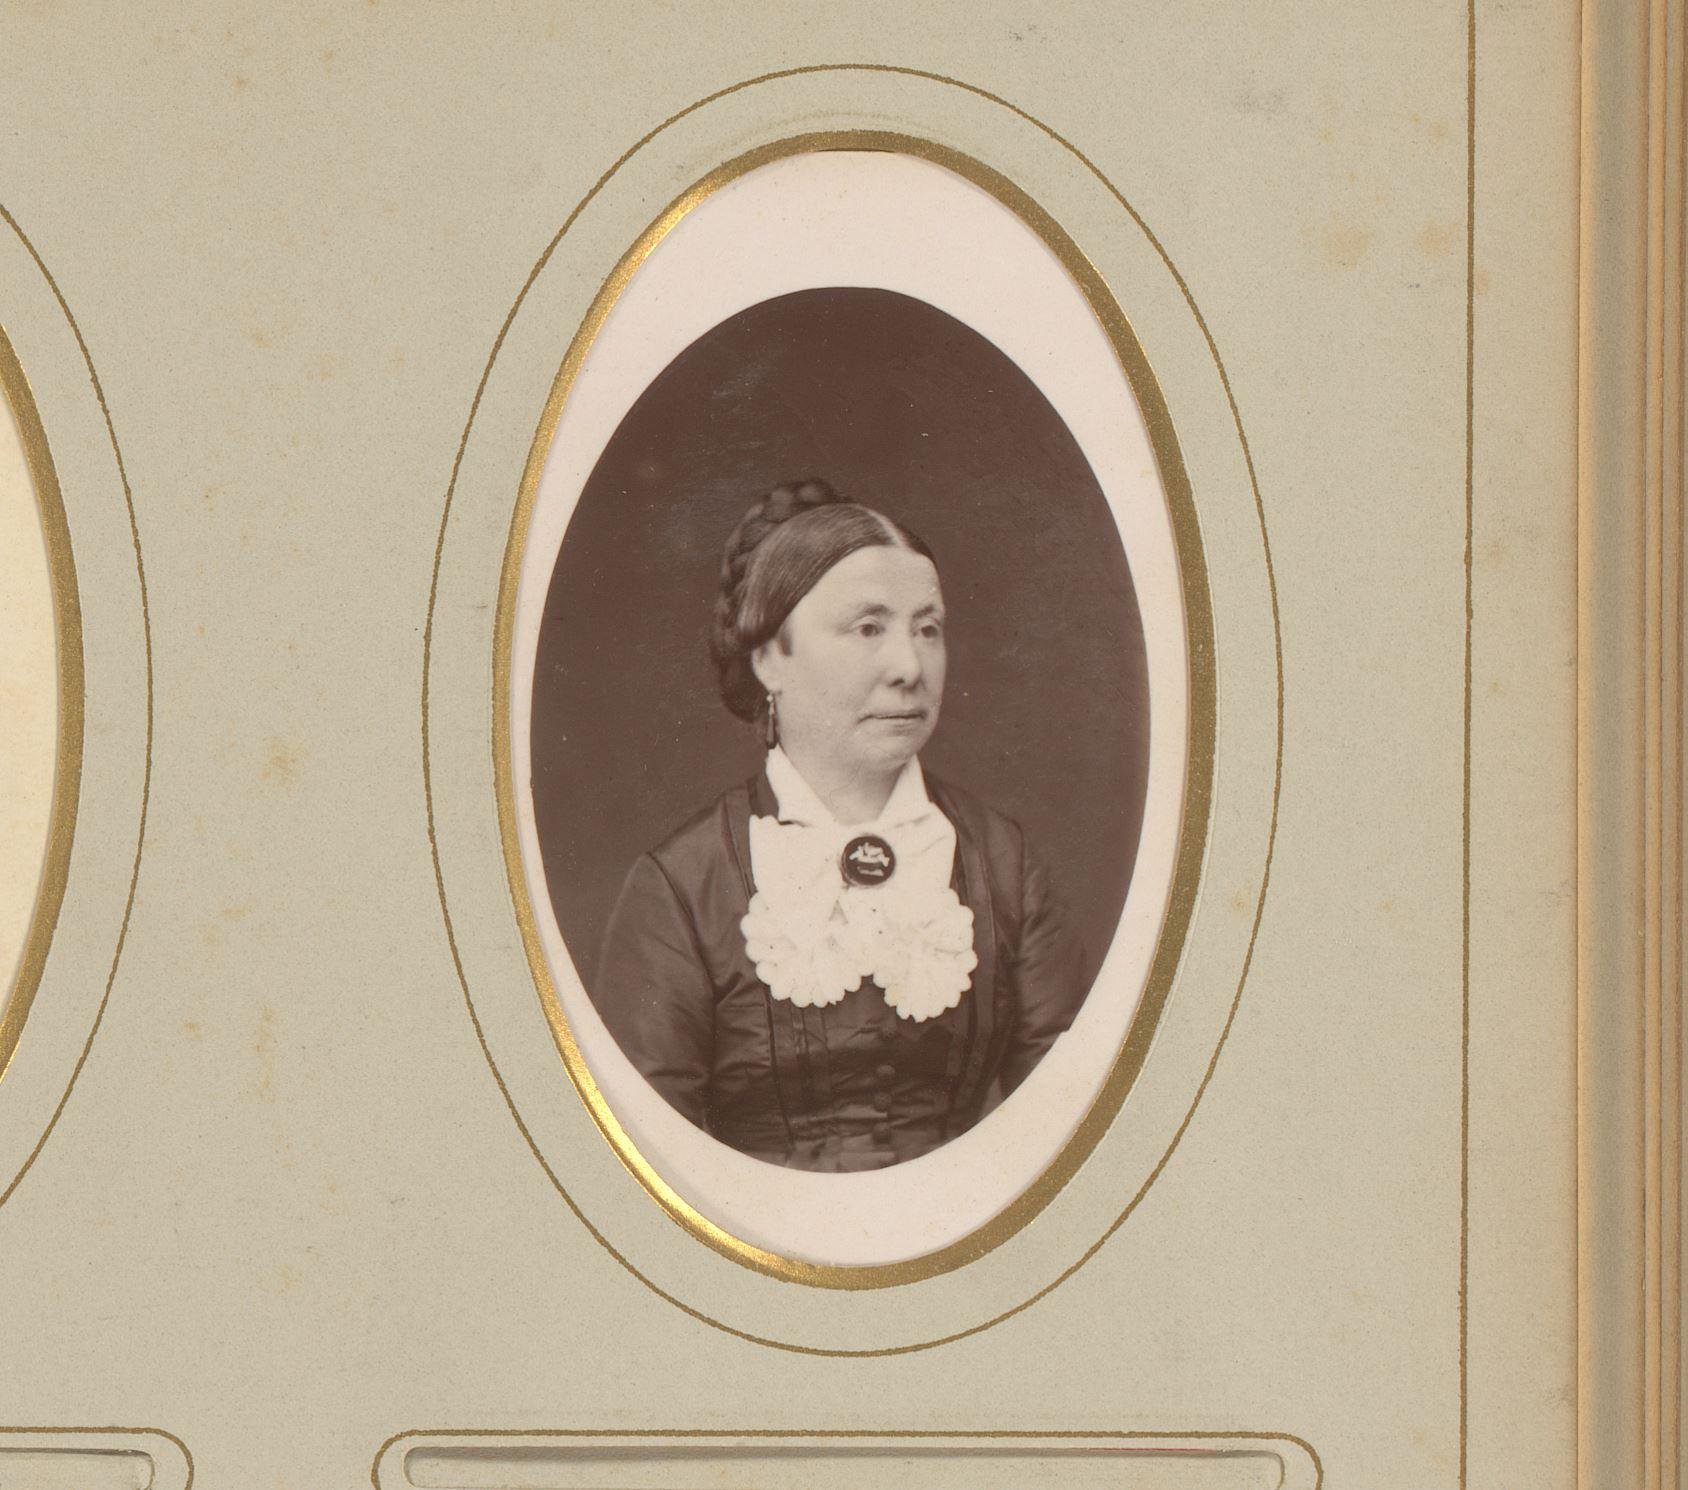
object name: semi enamel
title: Portret van een vrouw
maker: Anonymous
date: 1880-1900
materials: cardboard, celluloid, photographic support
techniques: albumen print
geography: ghent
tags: historical persons - bb - woman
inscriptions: inscription: ‘GAND/ RUE DE LA CORNE No 1/ COIN DE LA RUE DES CHAMPS/ 12 PORTRAITS INALTÉRABLES/ FRS 3 50’